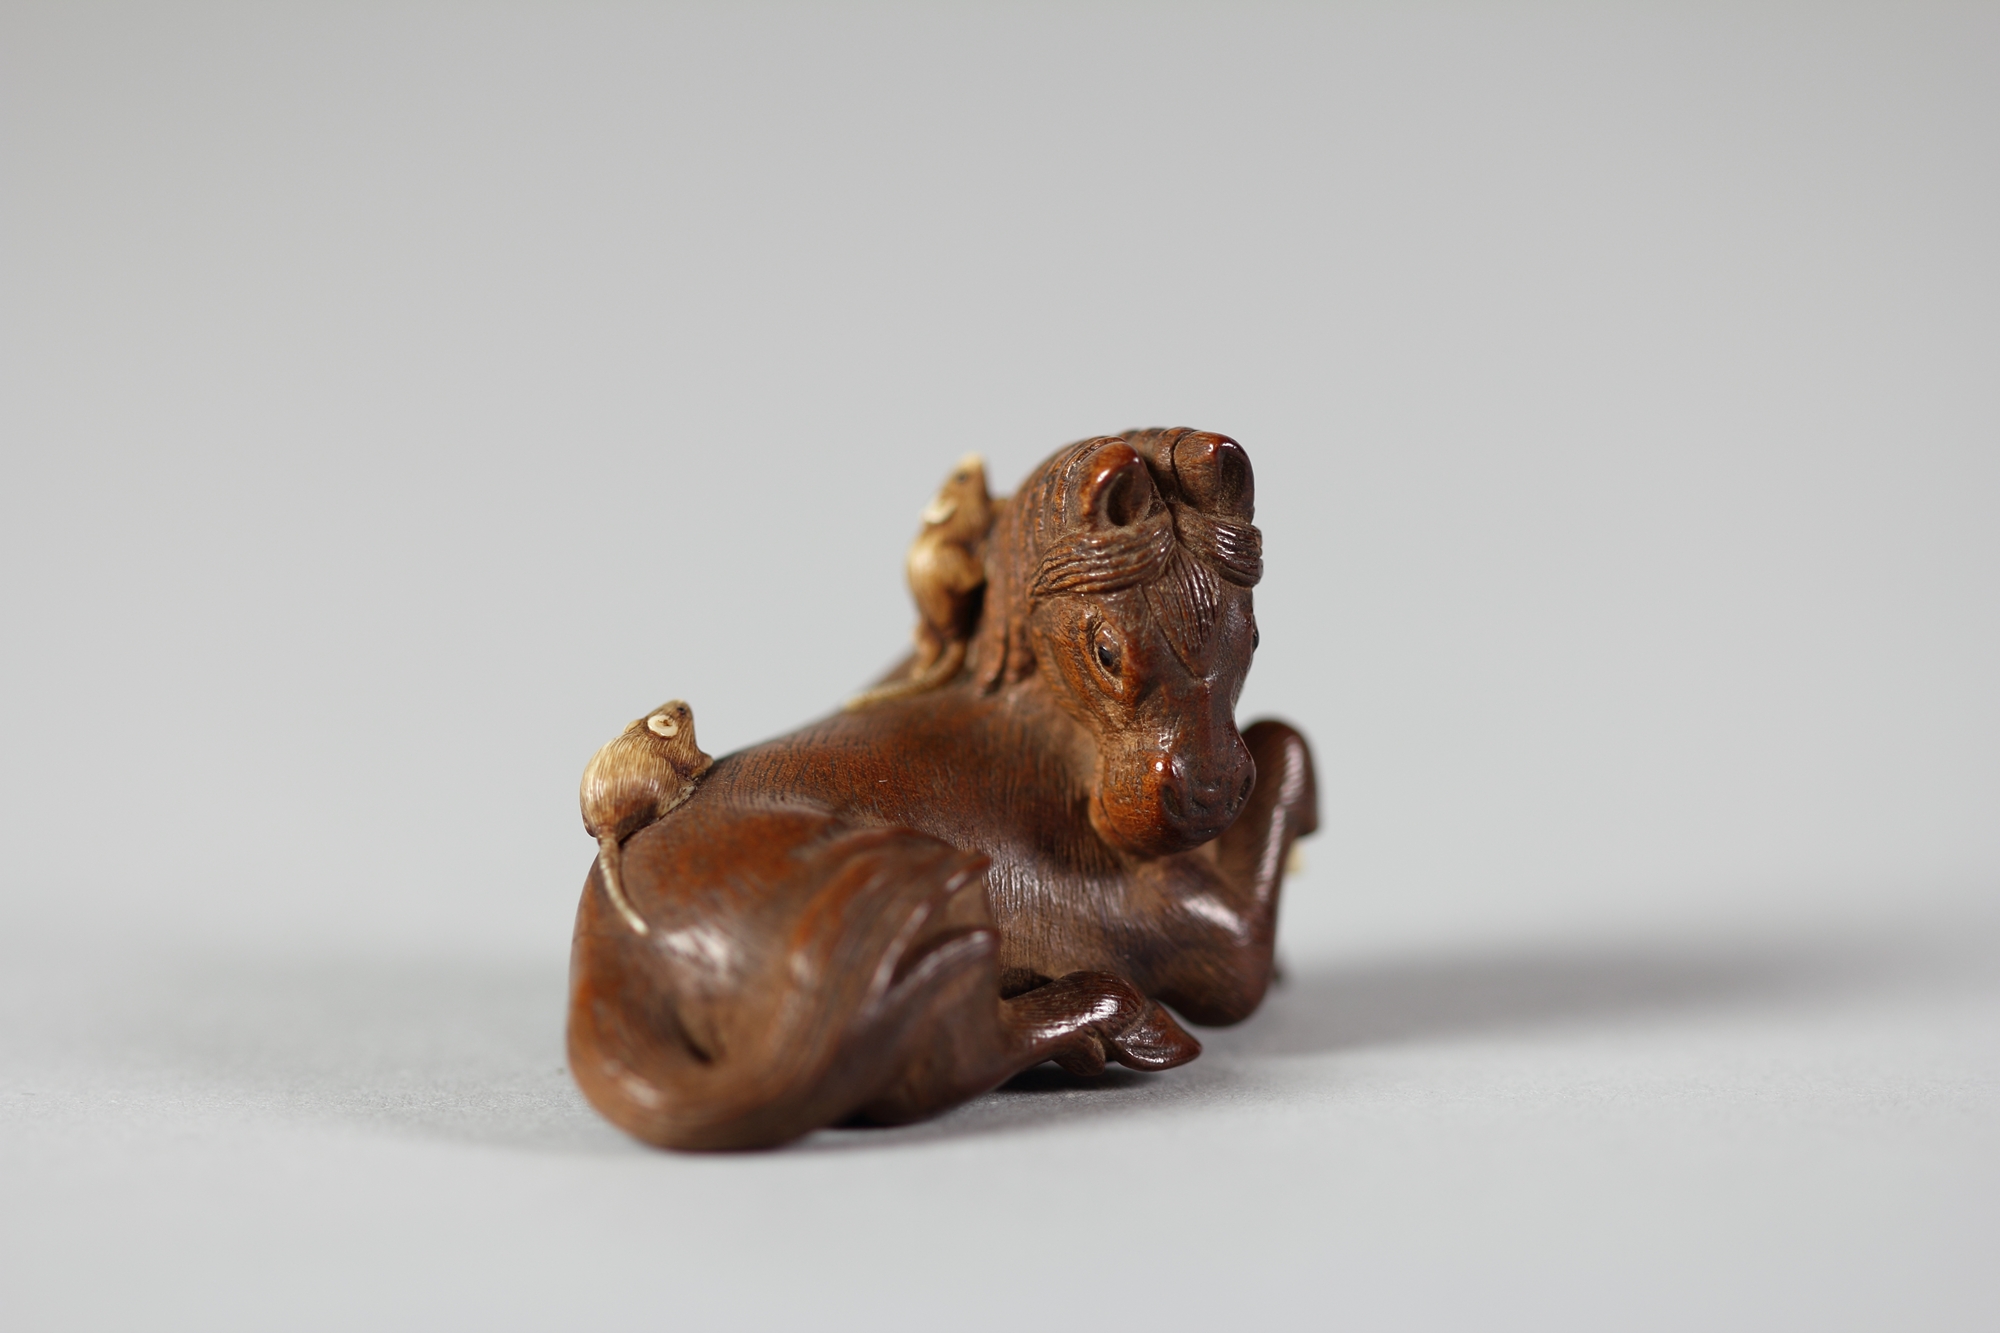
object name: netsuke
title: Netsuke of Horse and Mouse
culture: japanese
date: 1801-1900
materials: wood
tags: horses,mice